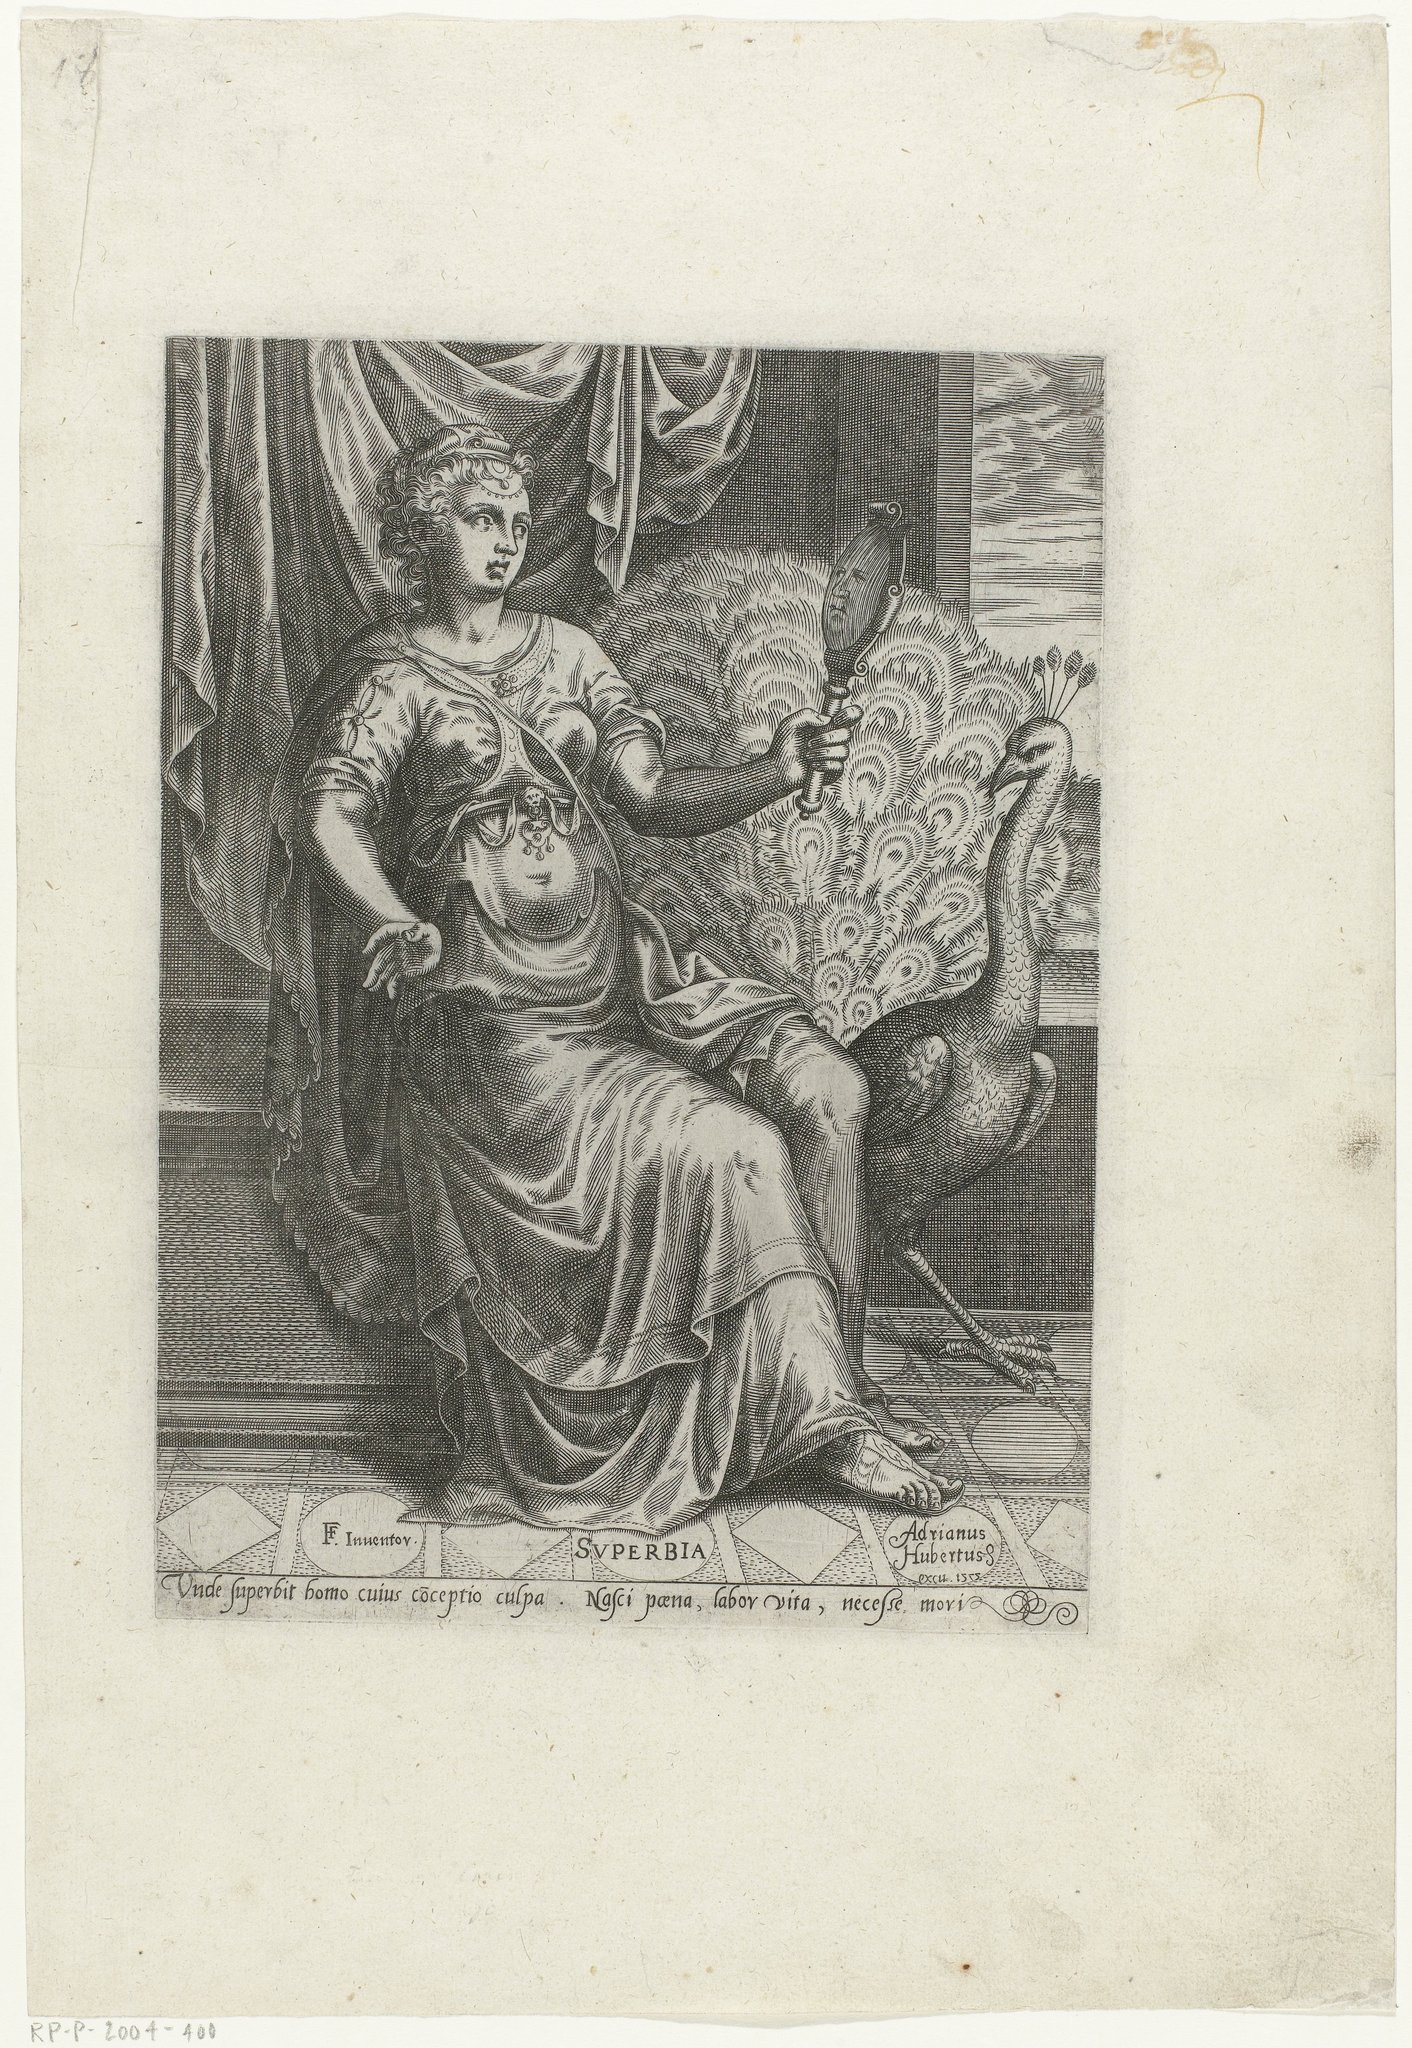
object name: print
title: Superbia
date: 1575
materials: paper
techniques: engraving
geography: low countries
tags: mirror, pride; 'superbia' (ripa) ~ personification of one of the seven deadly sins, ornamental birds: peacock, (woman) looking in a mirror ~ scene symbolizing 'vanitas'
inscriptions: collector's mark: Lugt 2760, collector's mark: Lugt 2228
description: Personificatie van Hoogmoed in de gedaante van een zittende vrouw, die in een bolle spiegel in haar hand kijkt. Achter haar een draperie. Naast haar de pauw als haar attribuut. In de marge een éénregelig onderschrift in het Latijn.